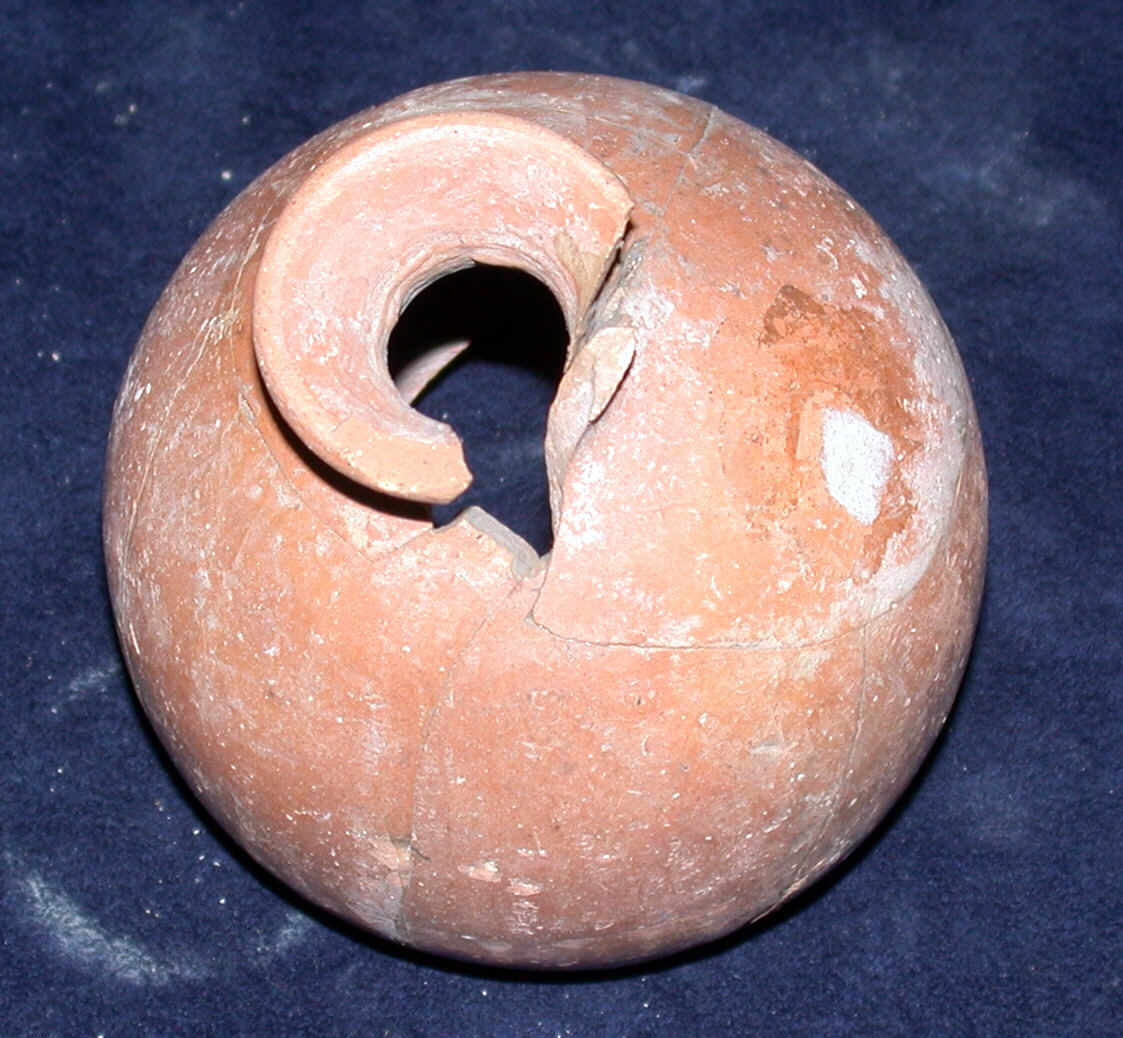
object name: bottle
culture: parthian or sasanian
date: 1-400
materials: ceramic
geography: iran